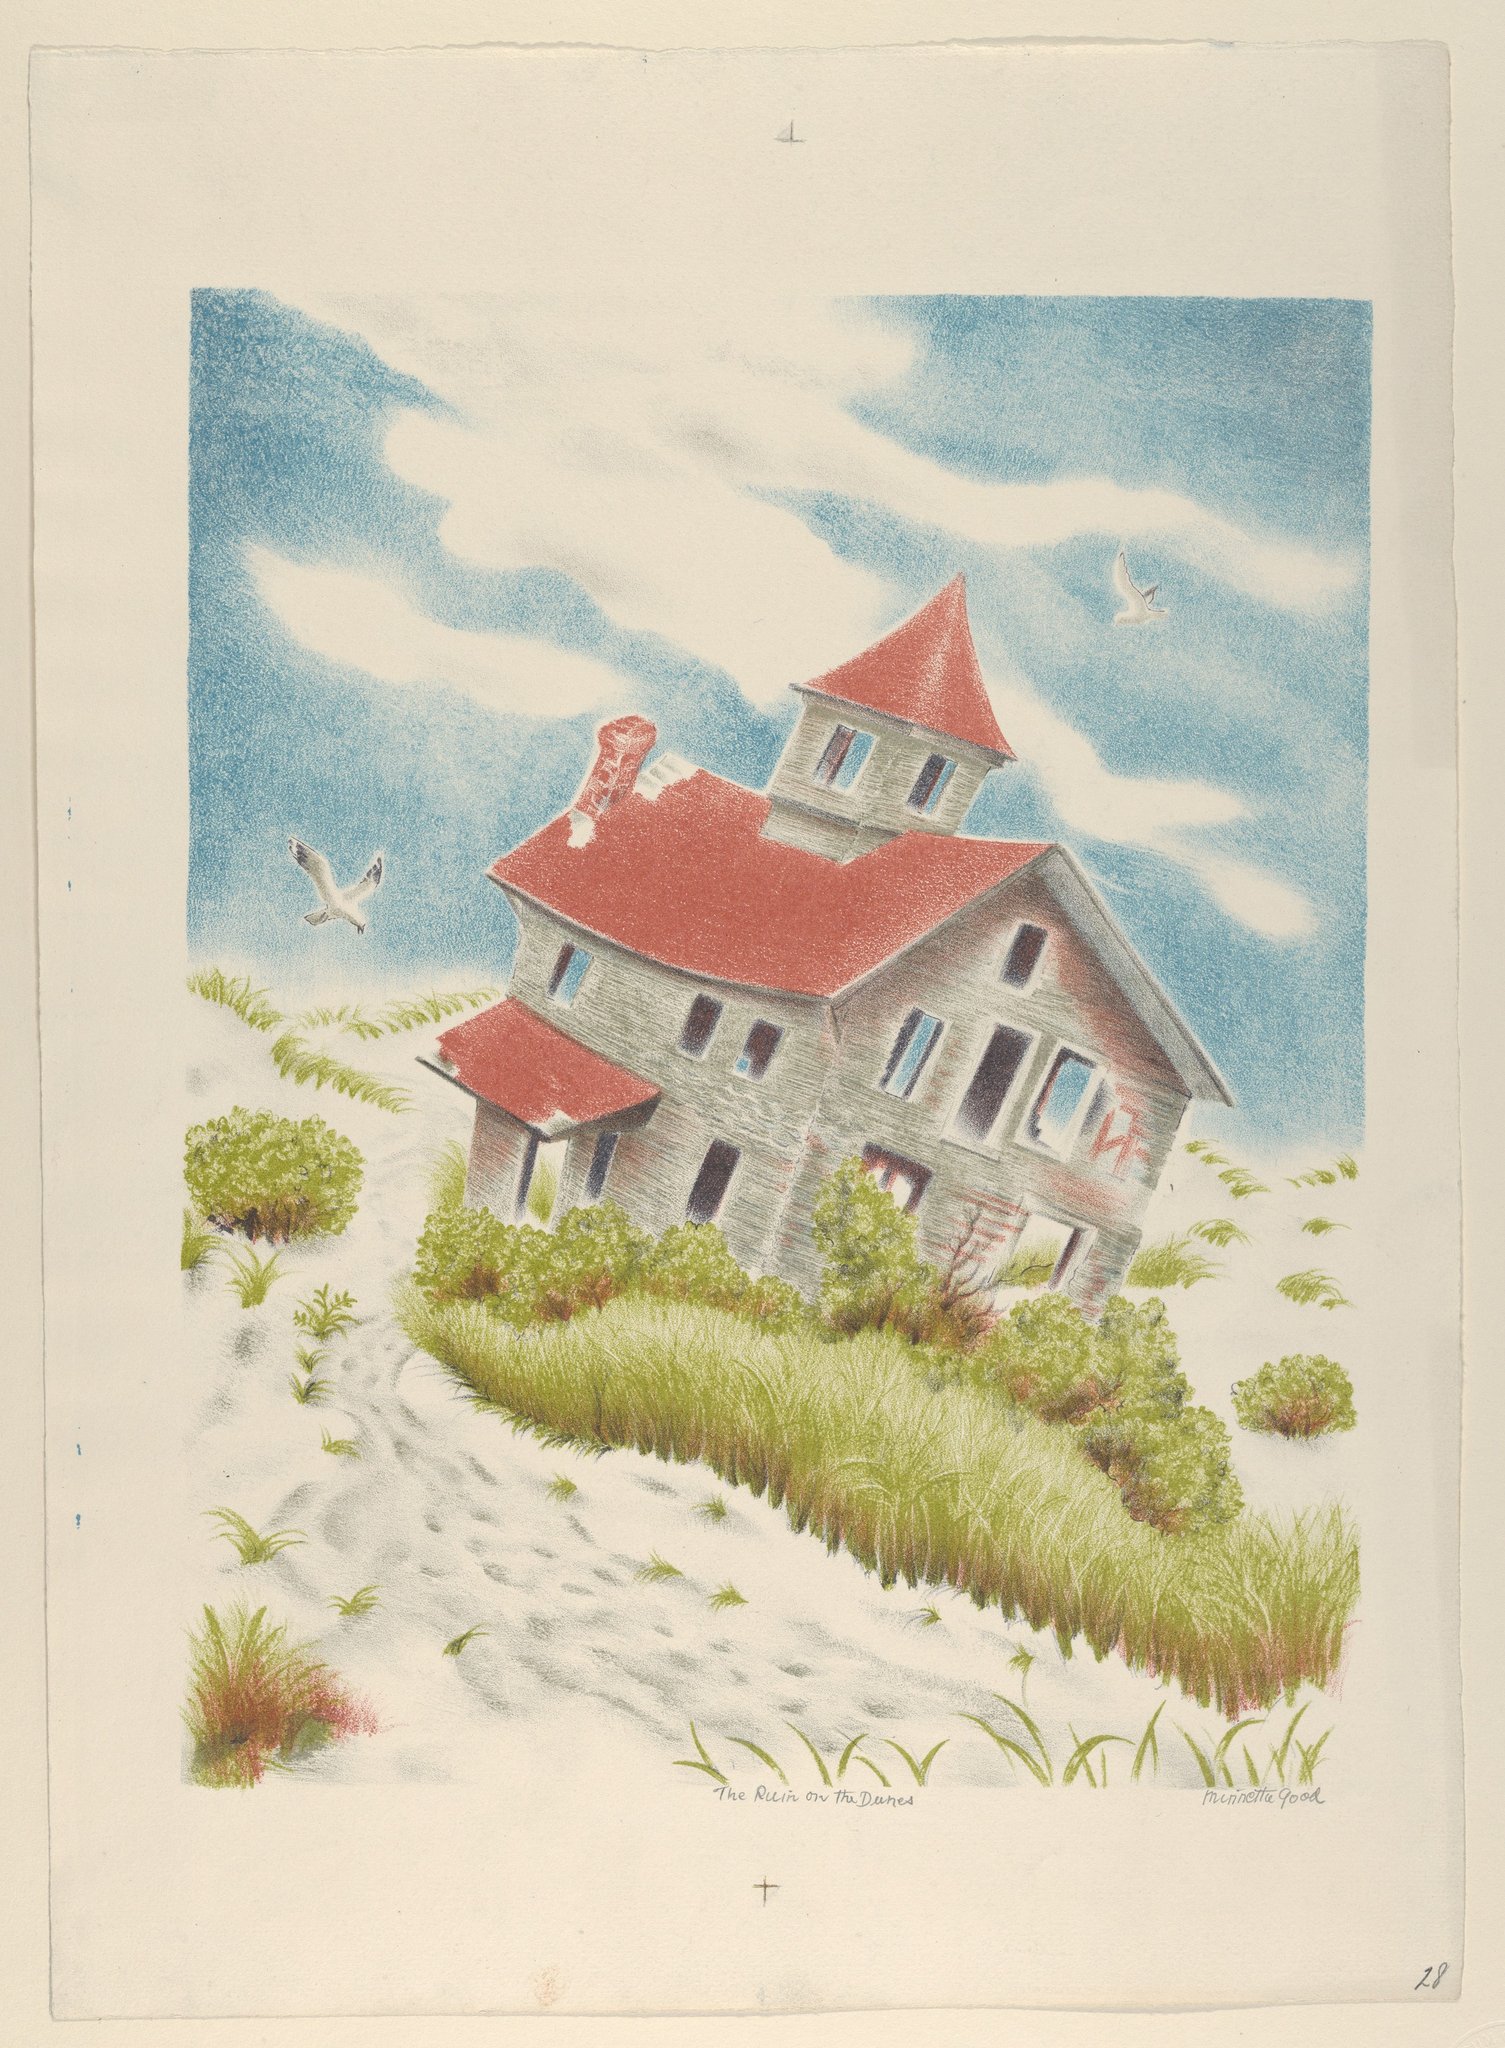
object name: print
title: The Ruin on The Dunes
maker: minnetta good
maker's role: artist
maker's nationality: american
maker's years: 1895-1946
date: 1935-1940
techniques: lithograph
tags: houses,snow